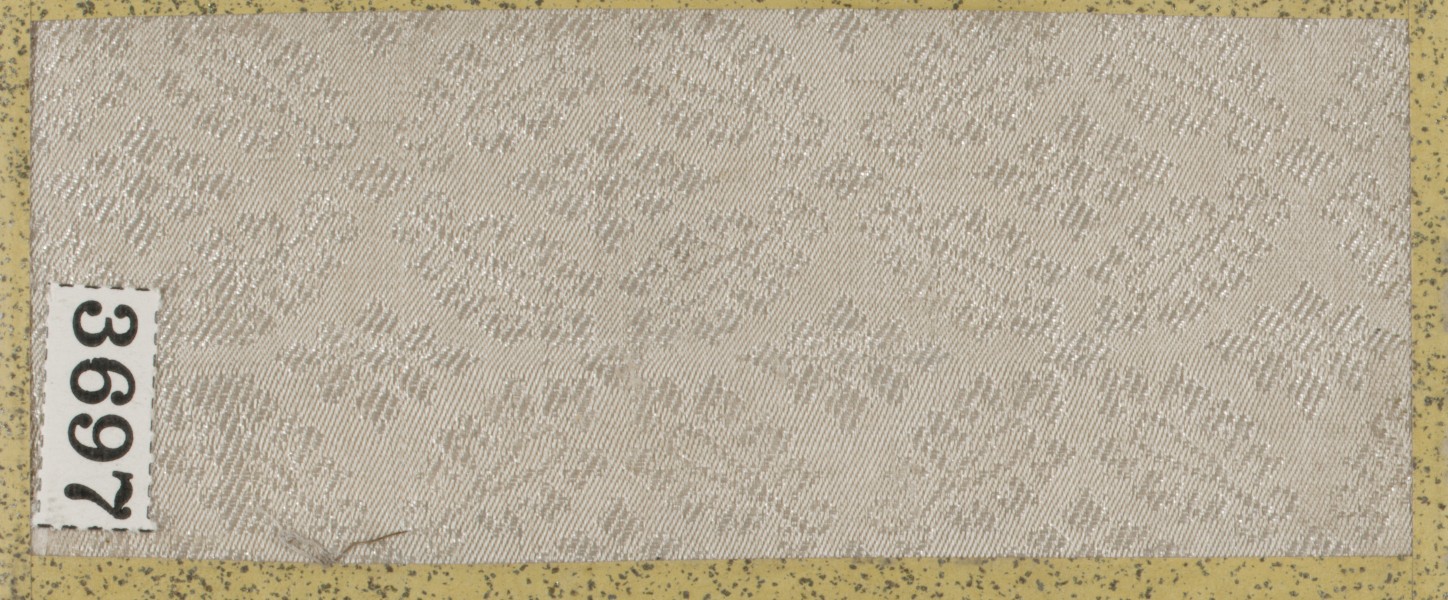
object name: sample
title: Textile Sample from Sample Book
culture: japanese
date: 1801-1900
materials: silk